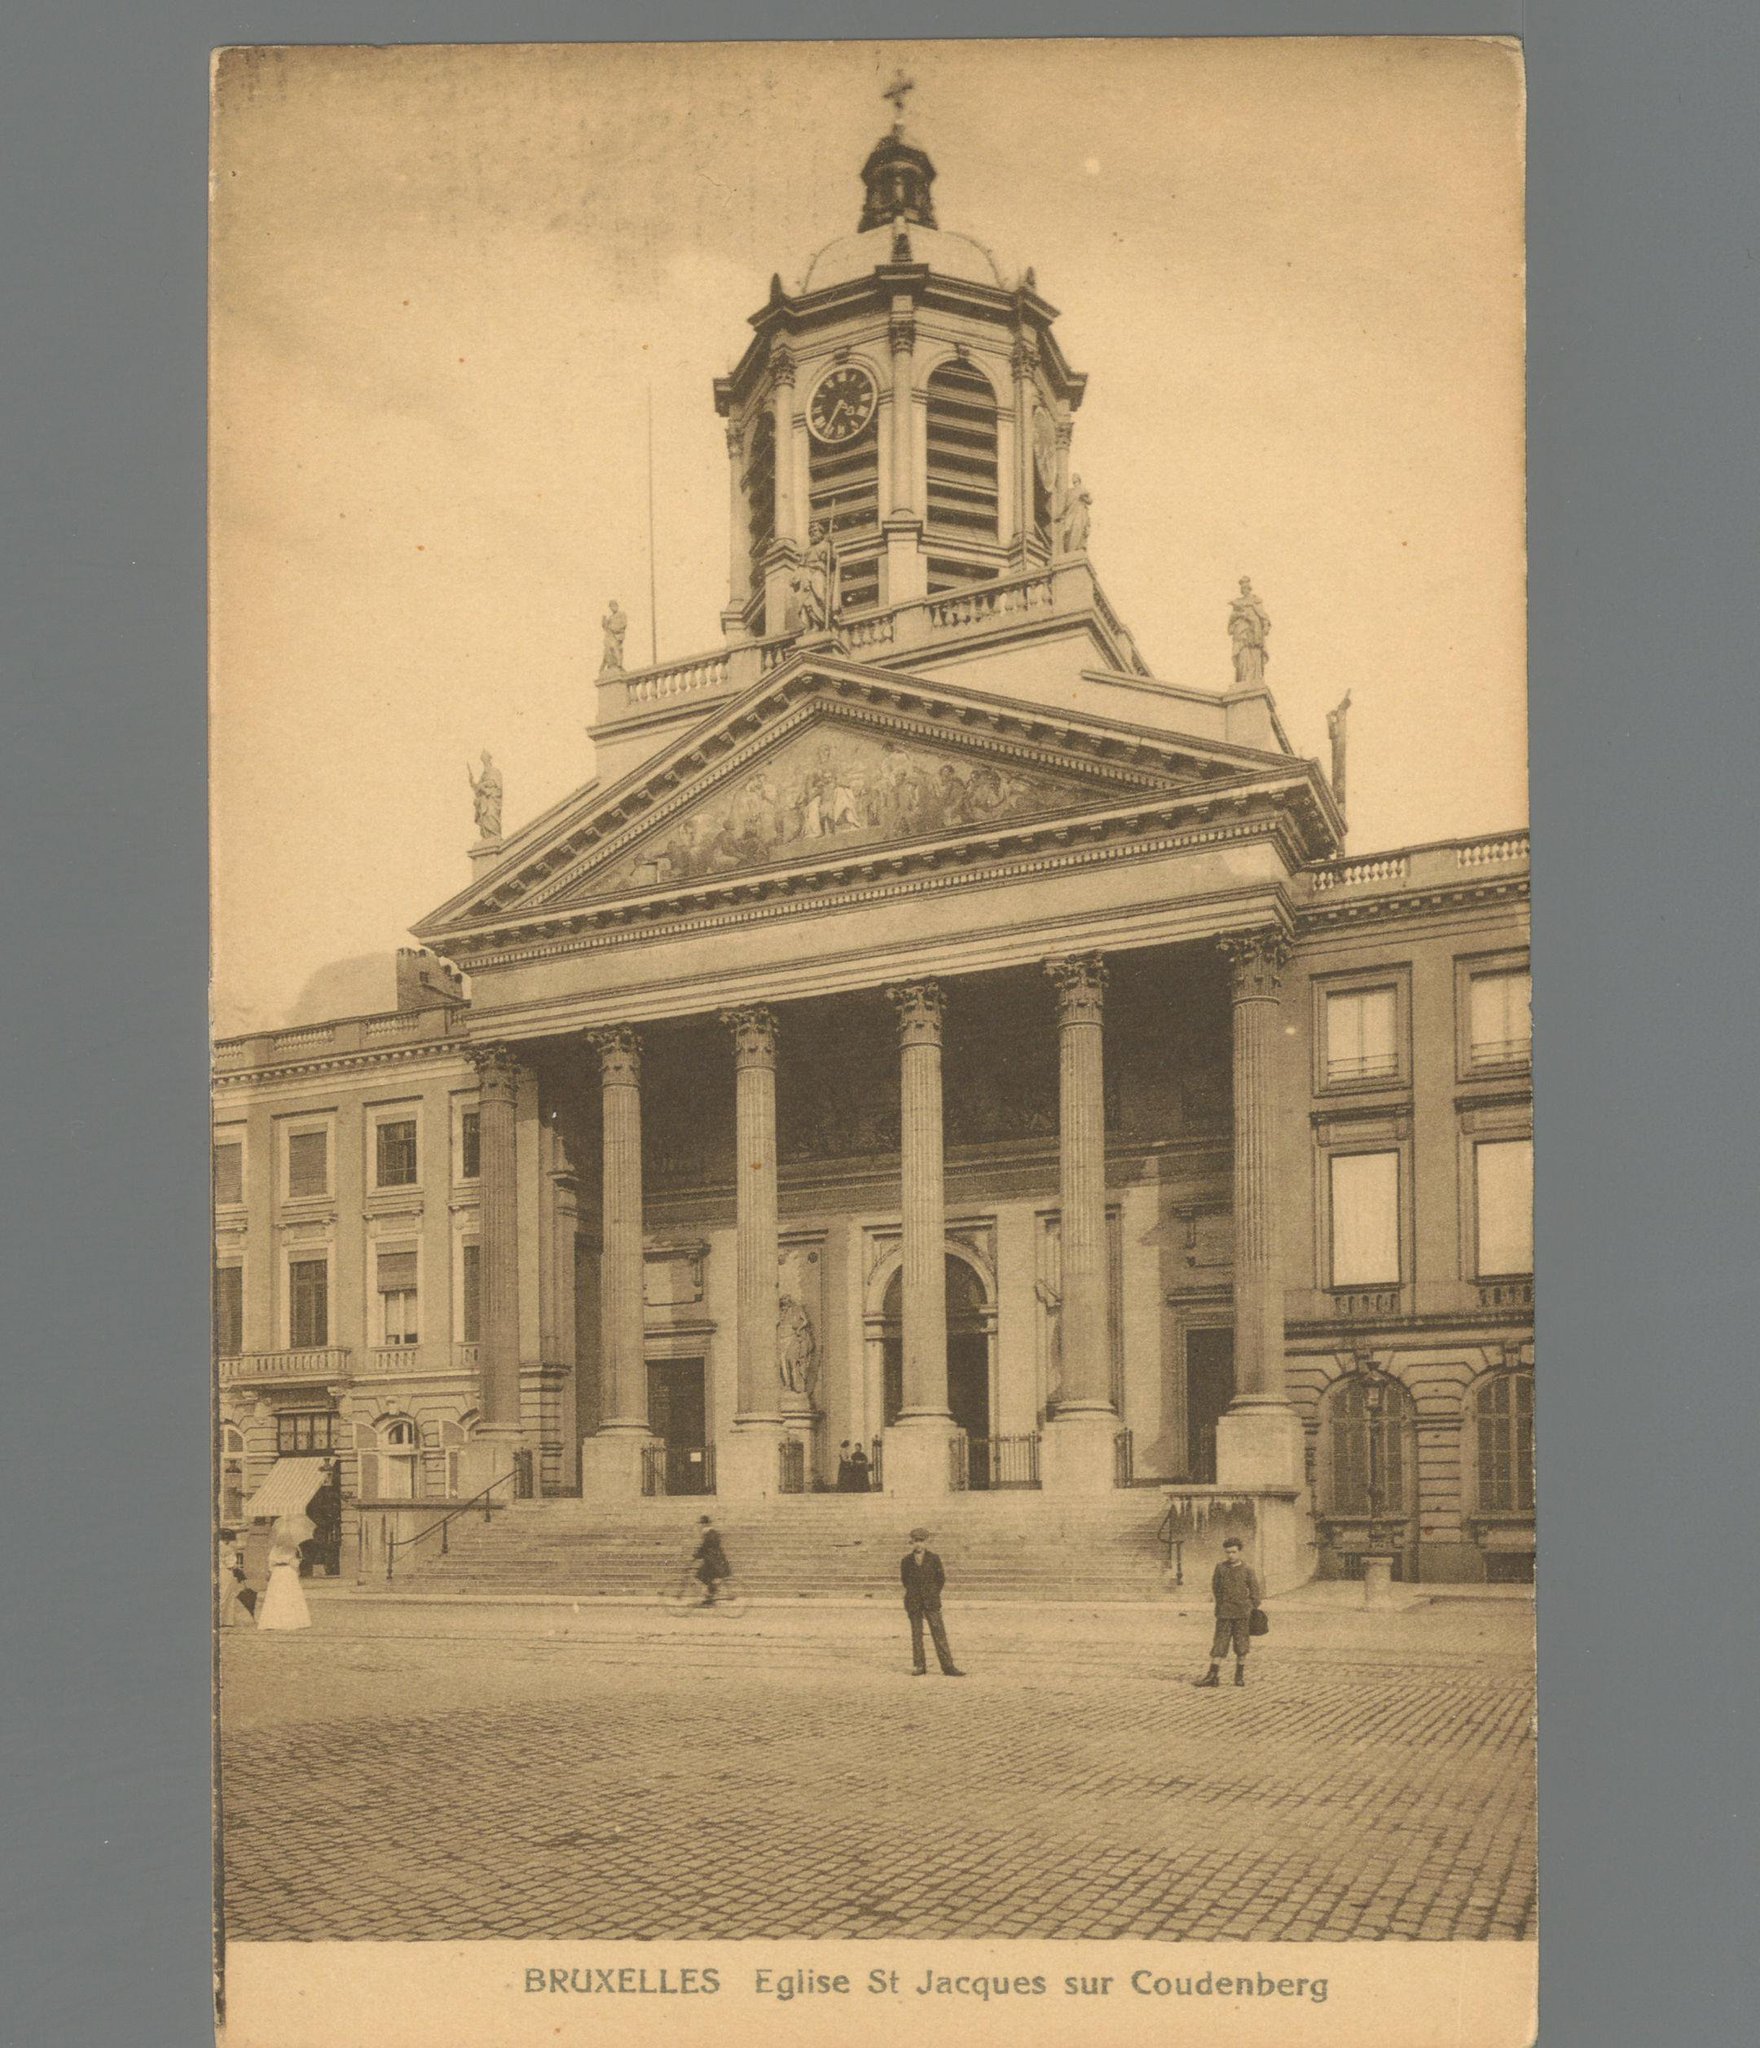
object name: photomechanical print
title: Bruxelles. Eglise St. Jacques sur Coudenberg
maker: Anonymous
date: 1906-1930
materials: cardboard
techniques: photograph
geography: brussels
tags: church (exterior), square, place, circus, etc. (+ city(-scape) with figures, staffage)